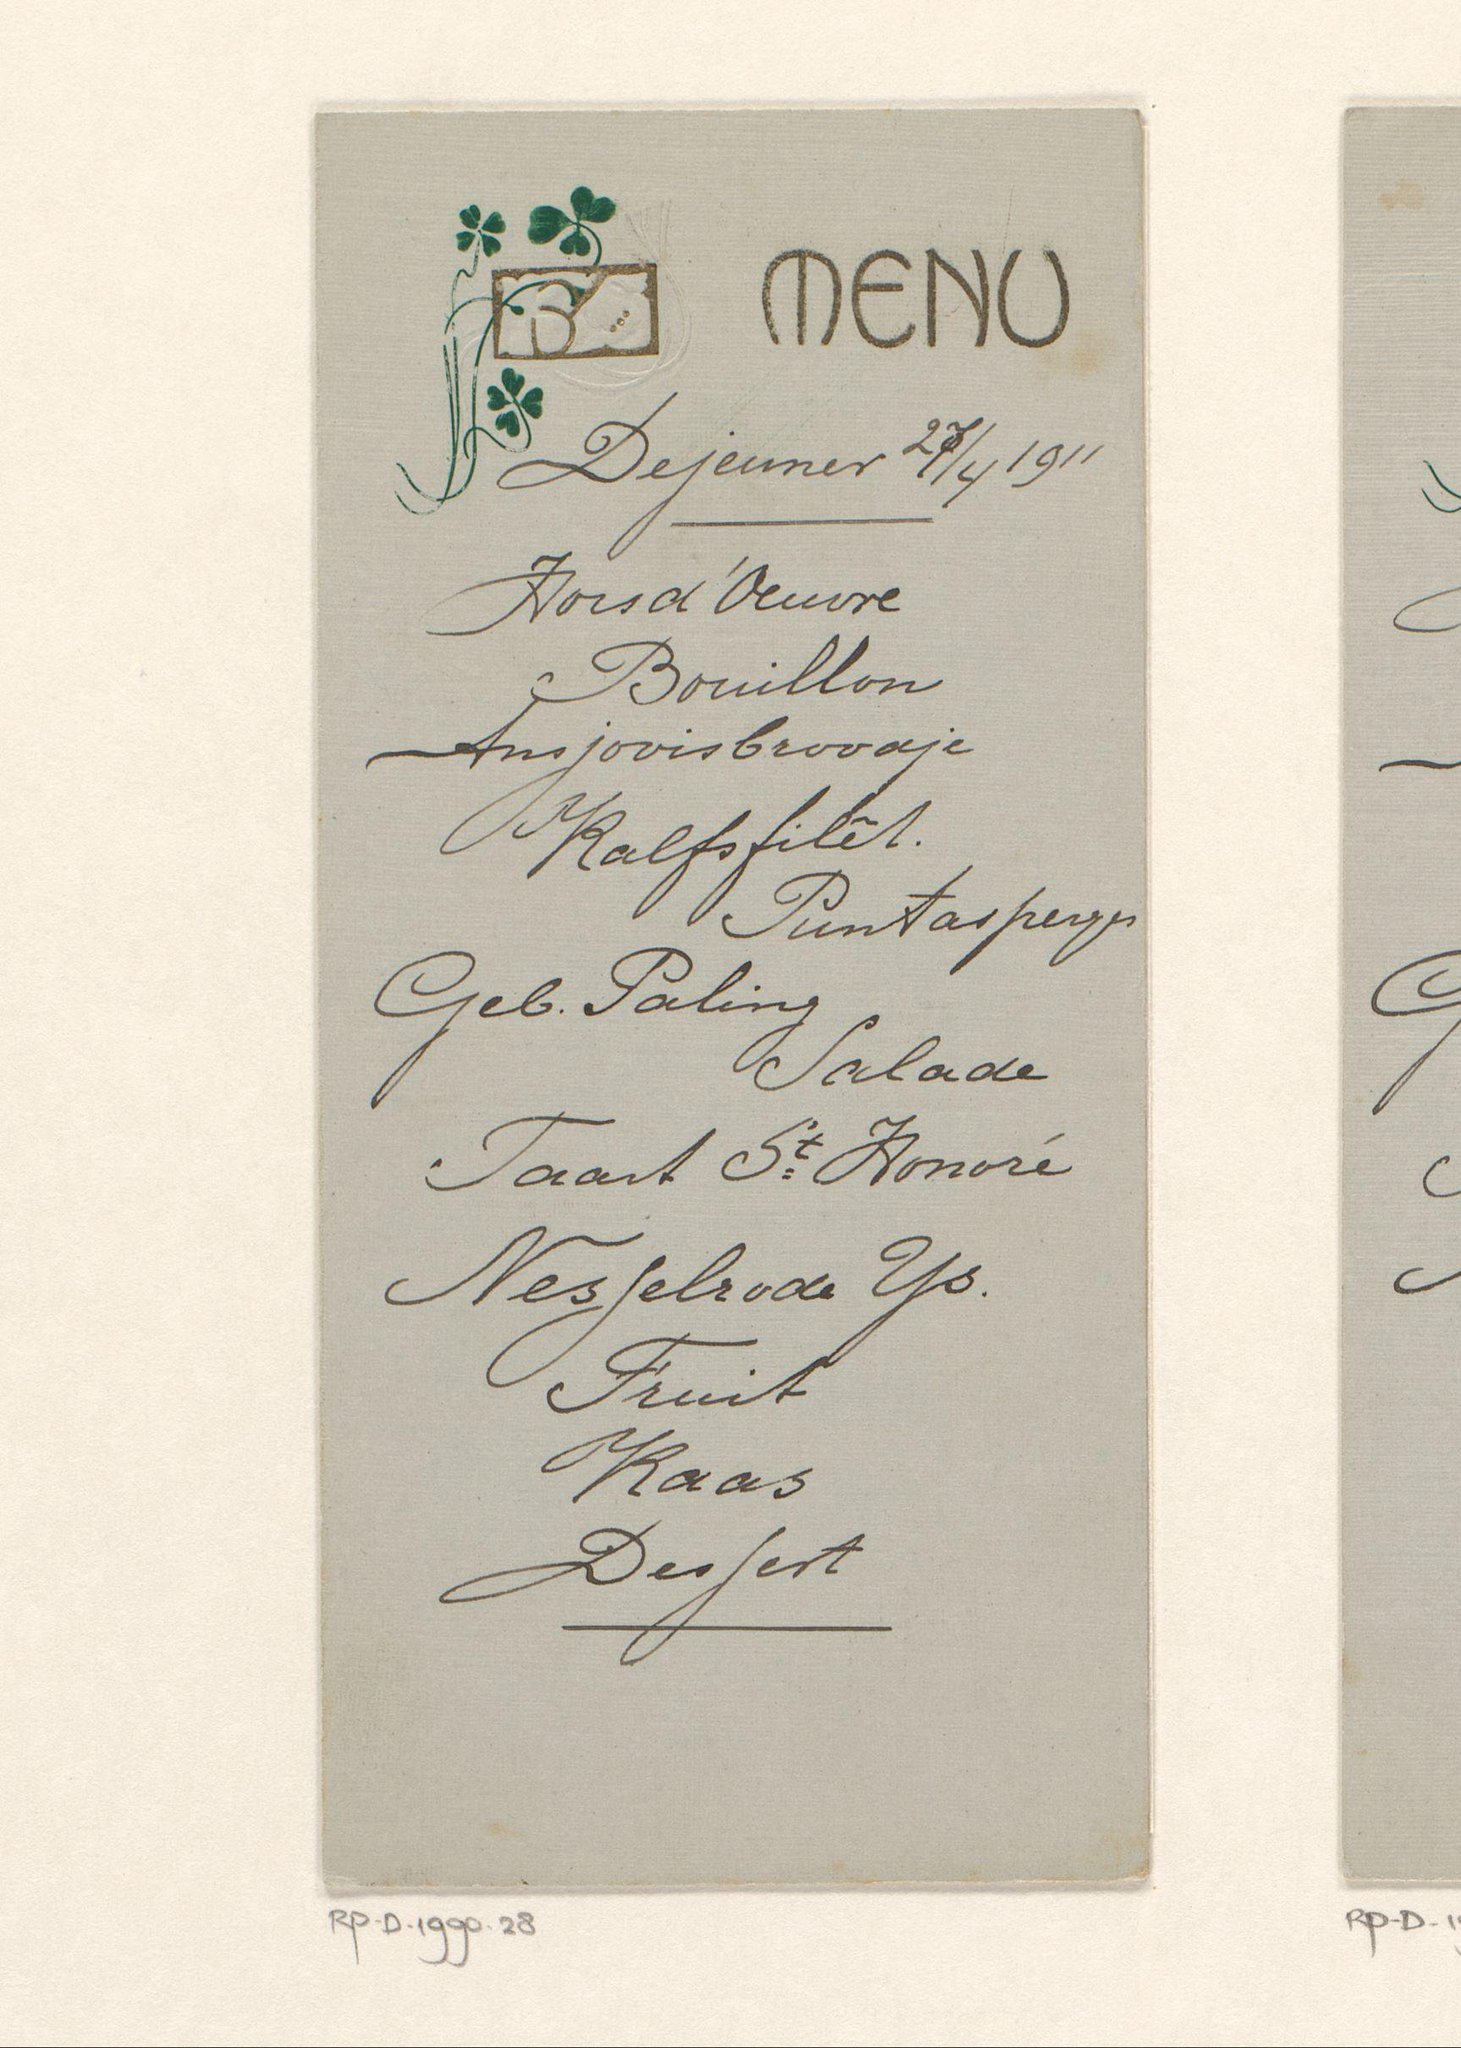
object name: menu, menukaart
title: Menukaart voor een ontbijt op 27 april 1911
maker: Anonymous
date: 1911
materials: paper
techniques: blind stamped, chromolithography, hand coloring, pen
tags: plants and herbs: clover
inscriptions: collector's mark: Lugt 2228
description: Bovenaan een vignet met klavertjes vier naast het woord 'Menu', daaronder het handgeschreven ontbijtmenu. Op de achterzijde handtekeningen (waarschijnlijk van de aanwezigen).